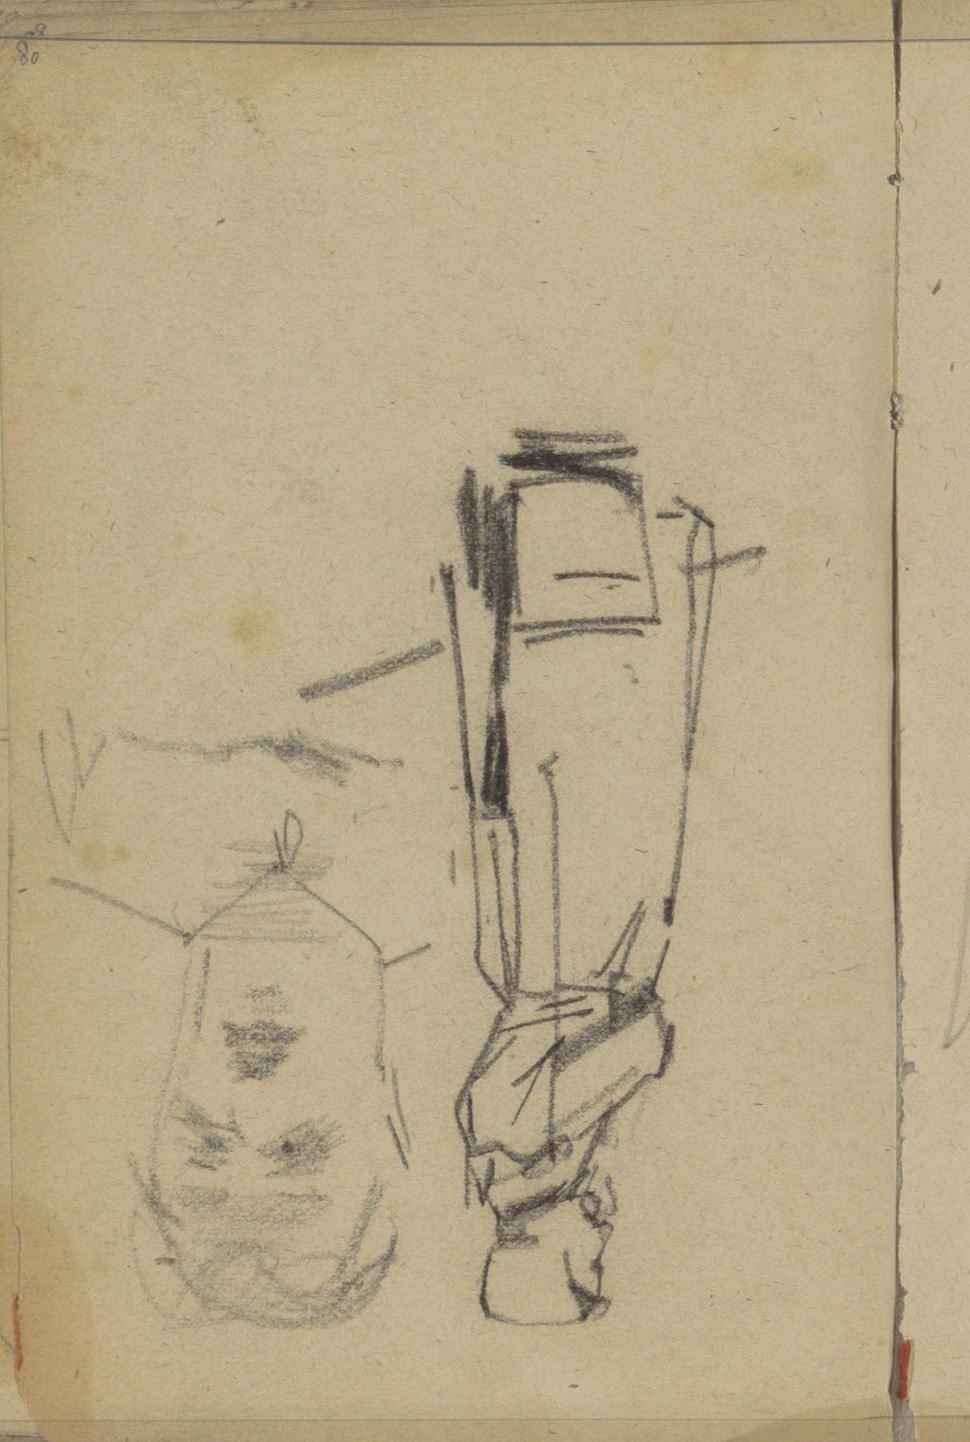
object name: sketchbook leaf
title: Staande vrouw en een mannenhoofd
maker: george hendrik breitner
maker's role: draughtsman, painter, print maker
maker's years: 1857-1923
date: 1881-1883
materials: chalk, paper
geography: south holland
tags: head (human) (+ front view), standing figure - aa - female human figure (+ sideview, profile)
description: Staande vrouw, in profiel naar links. Op haar schouders mogelijk een juk. Verder een mannenhoofd. Pagina 80 uit een schetsboek met 70 bladen.